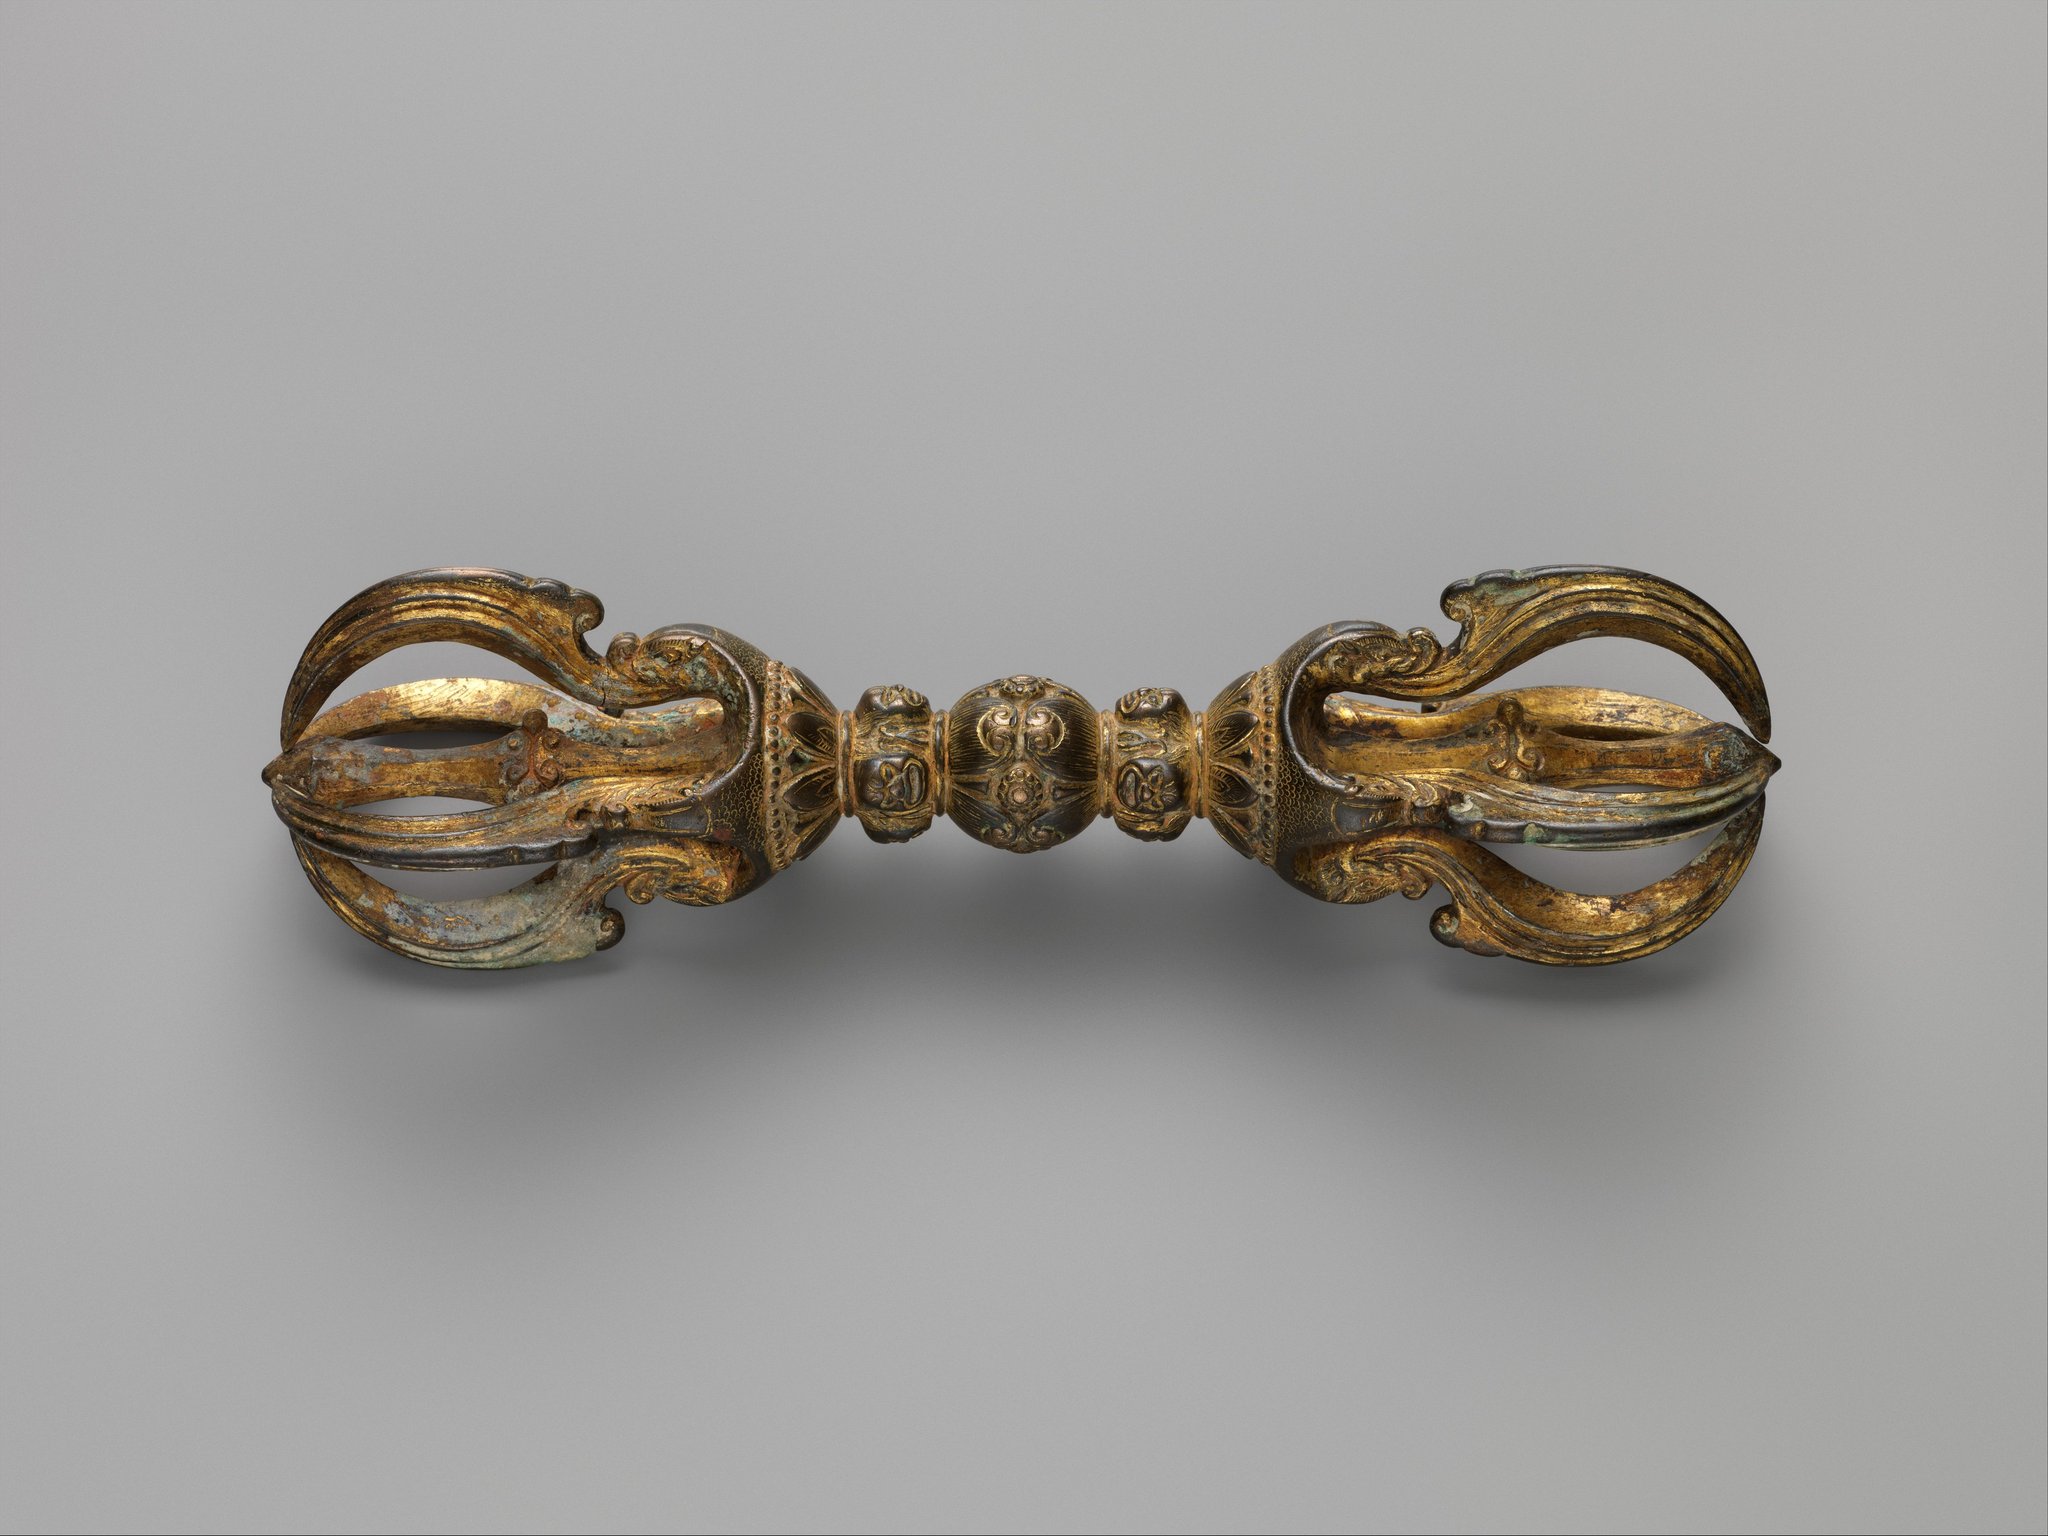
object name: vajra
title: Vajra with Angry Heads and Makara Prongs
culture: chinese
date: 618-907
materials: gilt bronze